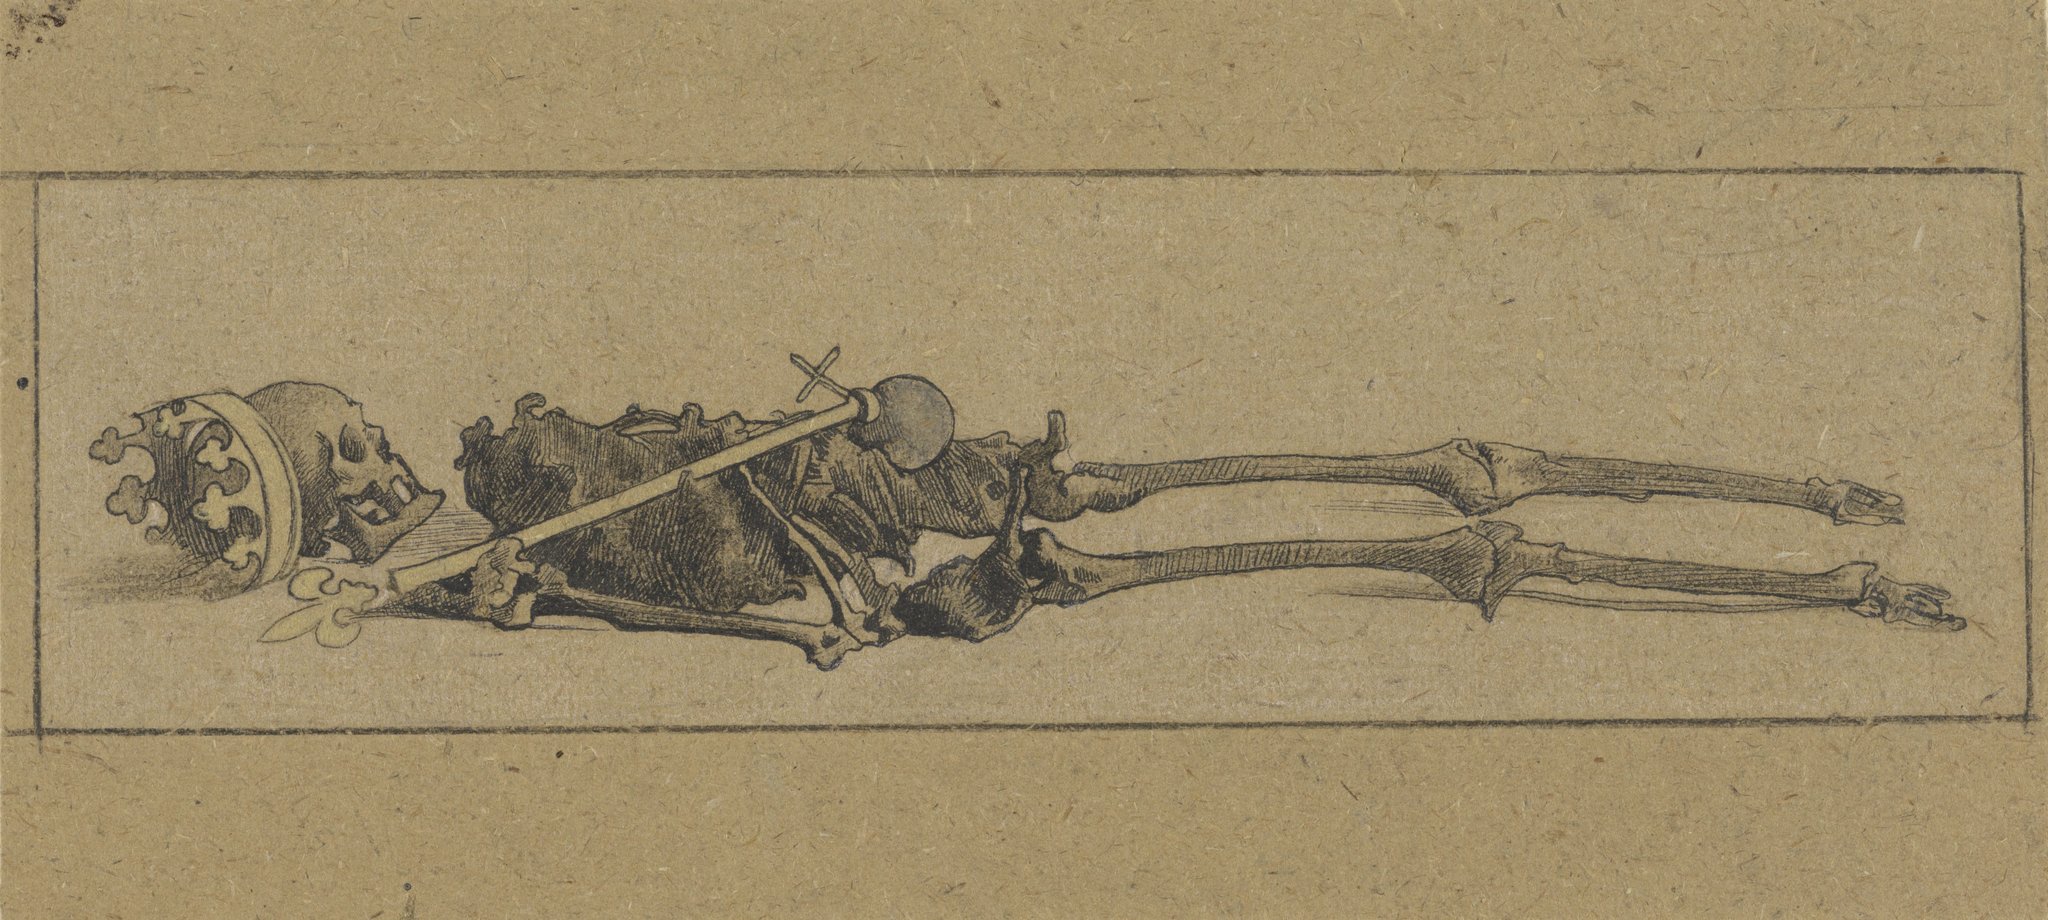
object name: drawing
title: Liggend skelet met kroon en scepter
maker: richard nicolaüs roland holst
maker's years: 1868-1938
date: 1878-1938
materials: cardboard, chalk, ink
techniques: pen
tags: ruler, sovereign, the corpse, (human) skeleton